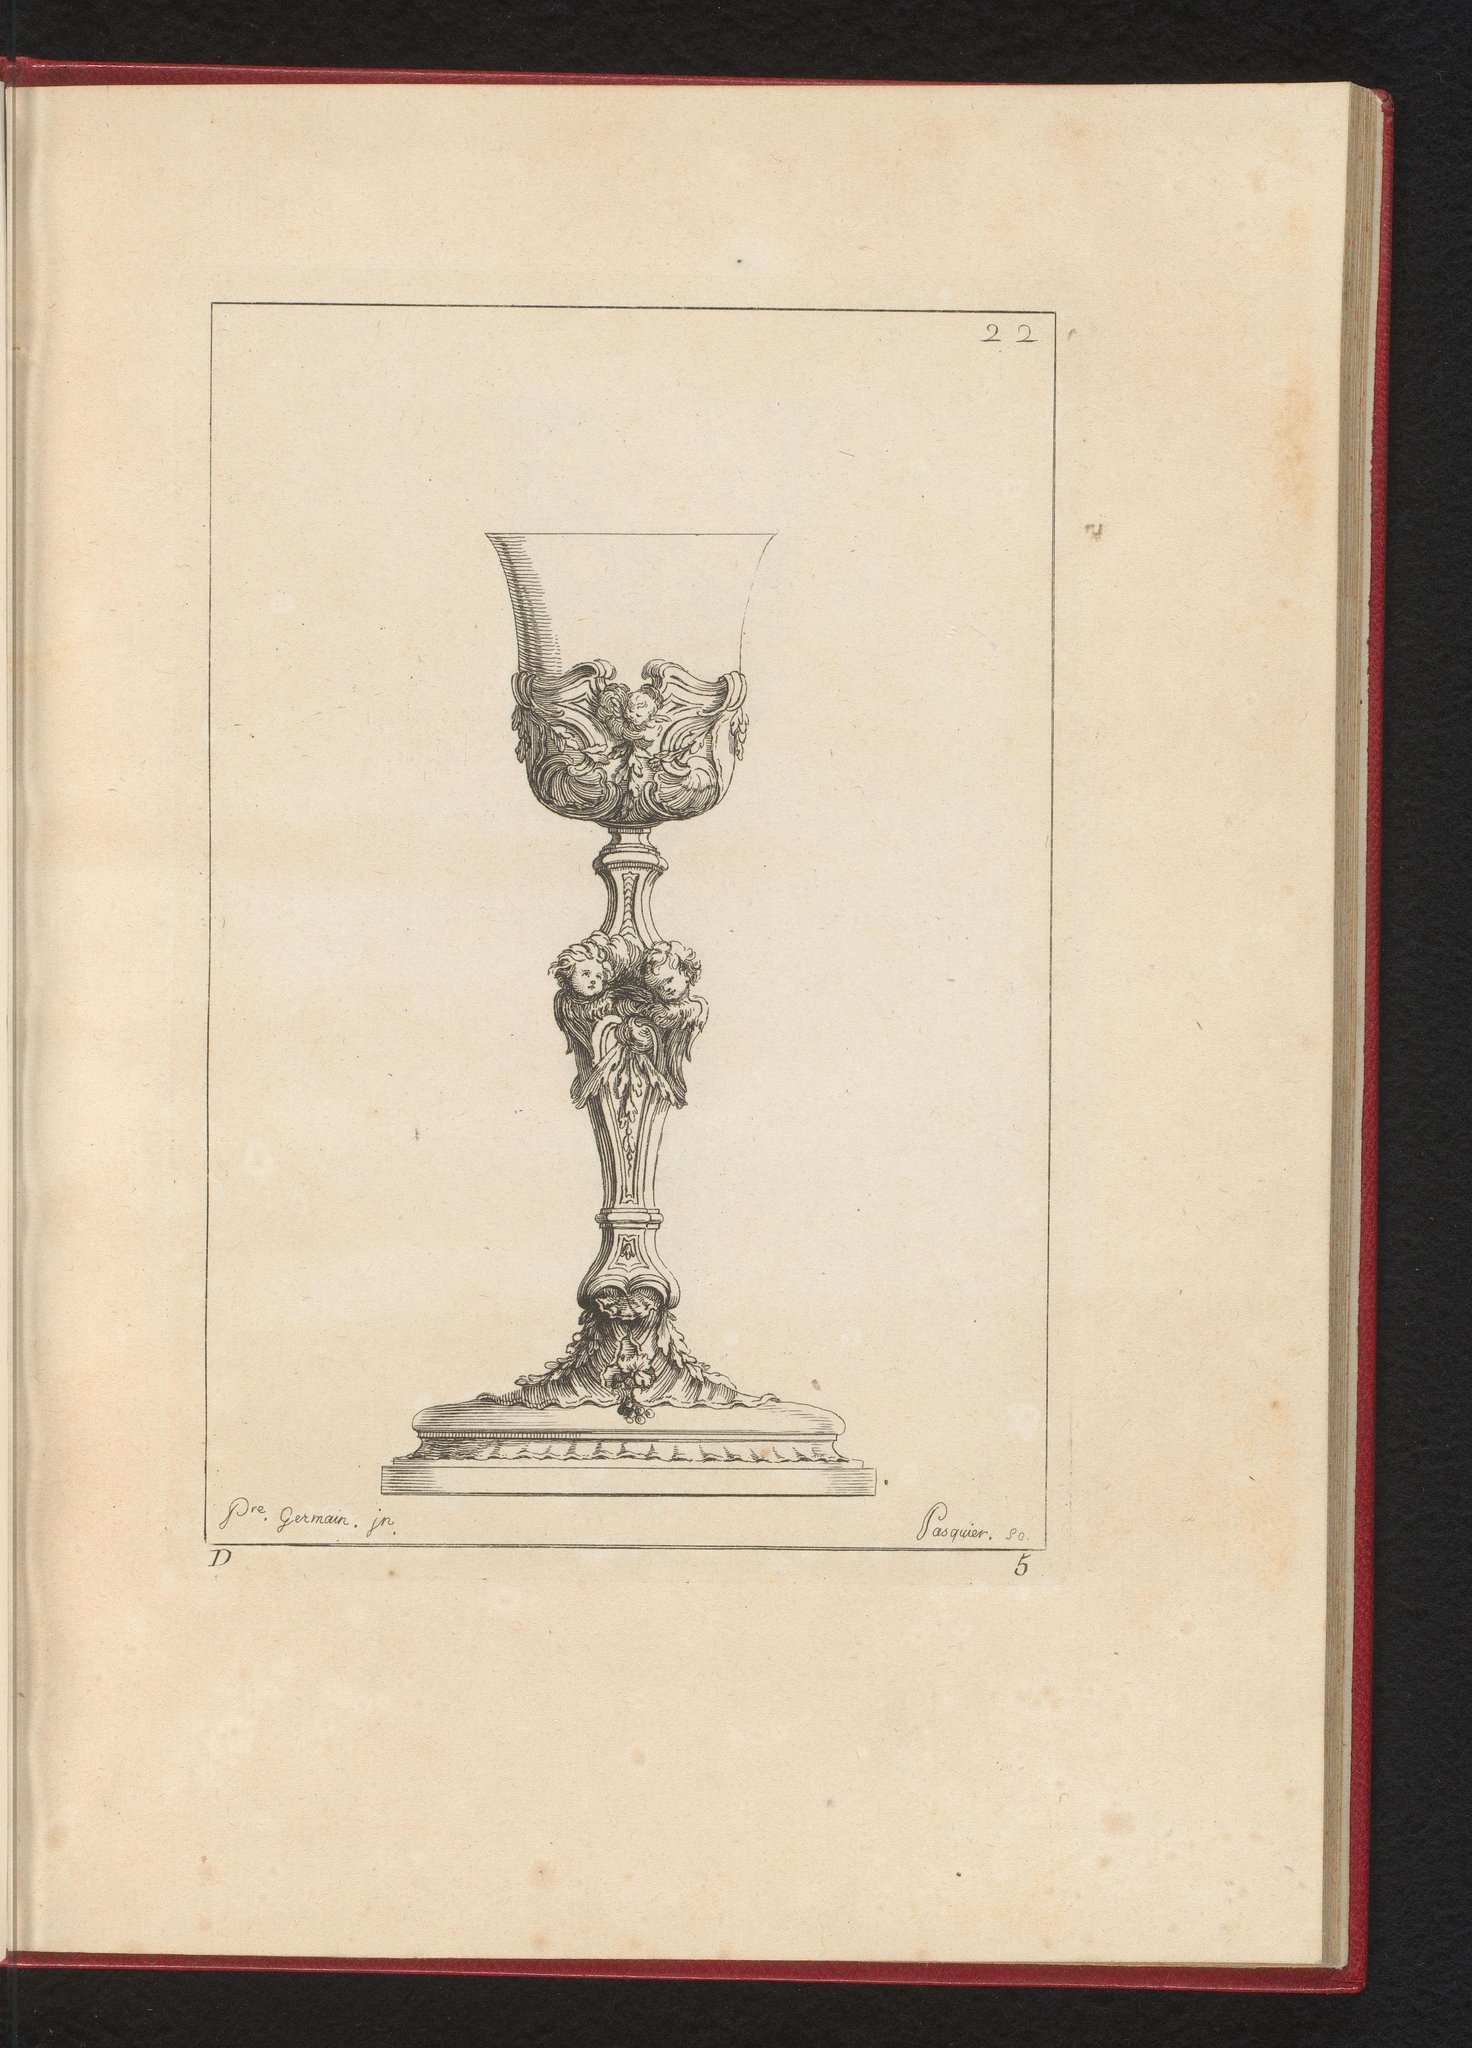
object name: album leaf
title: Zilverwerk en edelsmeedkunst, eerste deel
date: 1748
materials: paper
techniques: etching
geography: paris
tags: chalice, jeweller, goldsmith, silversmith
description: Een aantal van de objecten in deze reeks heeft een eigen ondertitel, die verwijst naar genummerde 'cahiers' (afleveringen) waarin de prenten werden uitgegeven. Het is onduidelijk welke objecten recies bij welke aflevering horen. Daarom is die ondertitel enkel verwerkt bij de prent waarop die voorkomt.